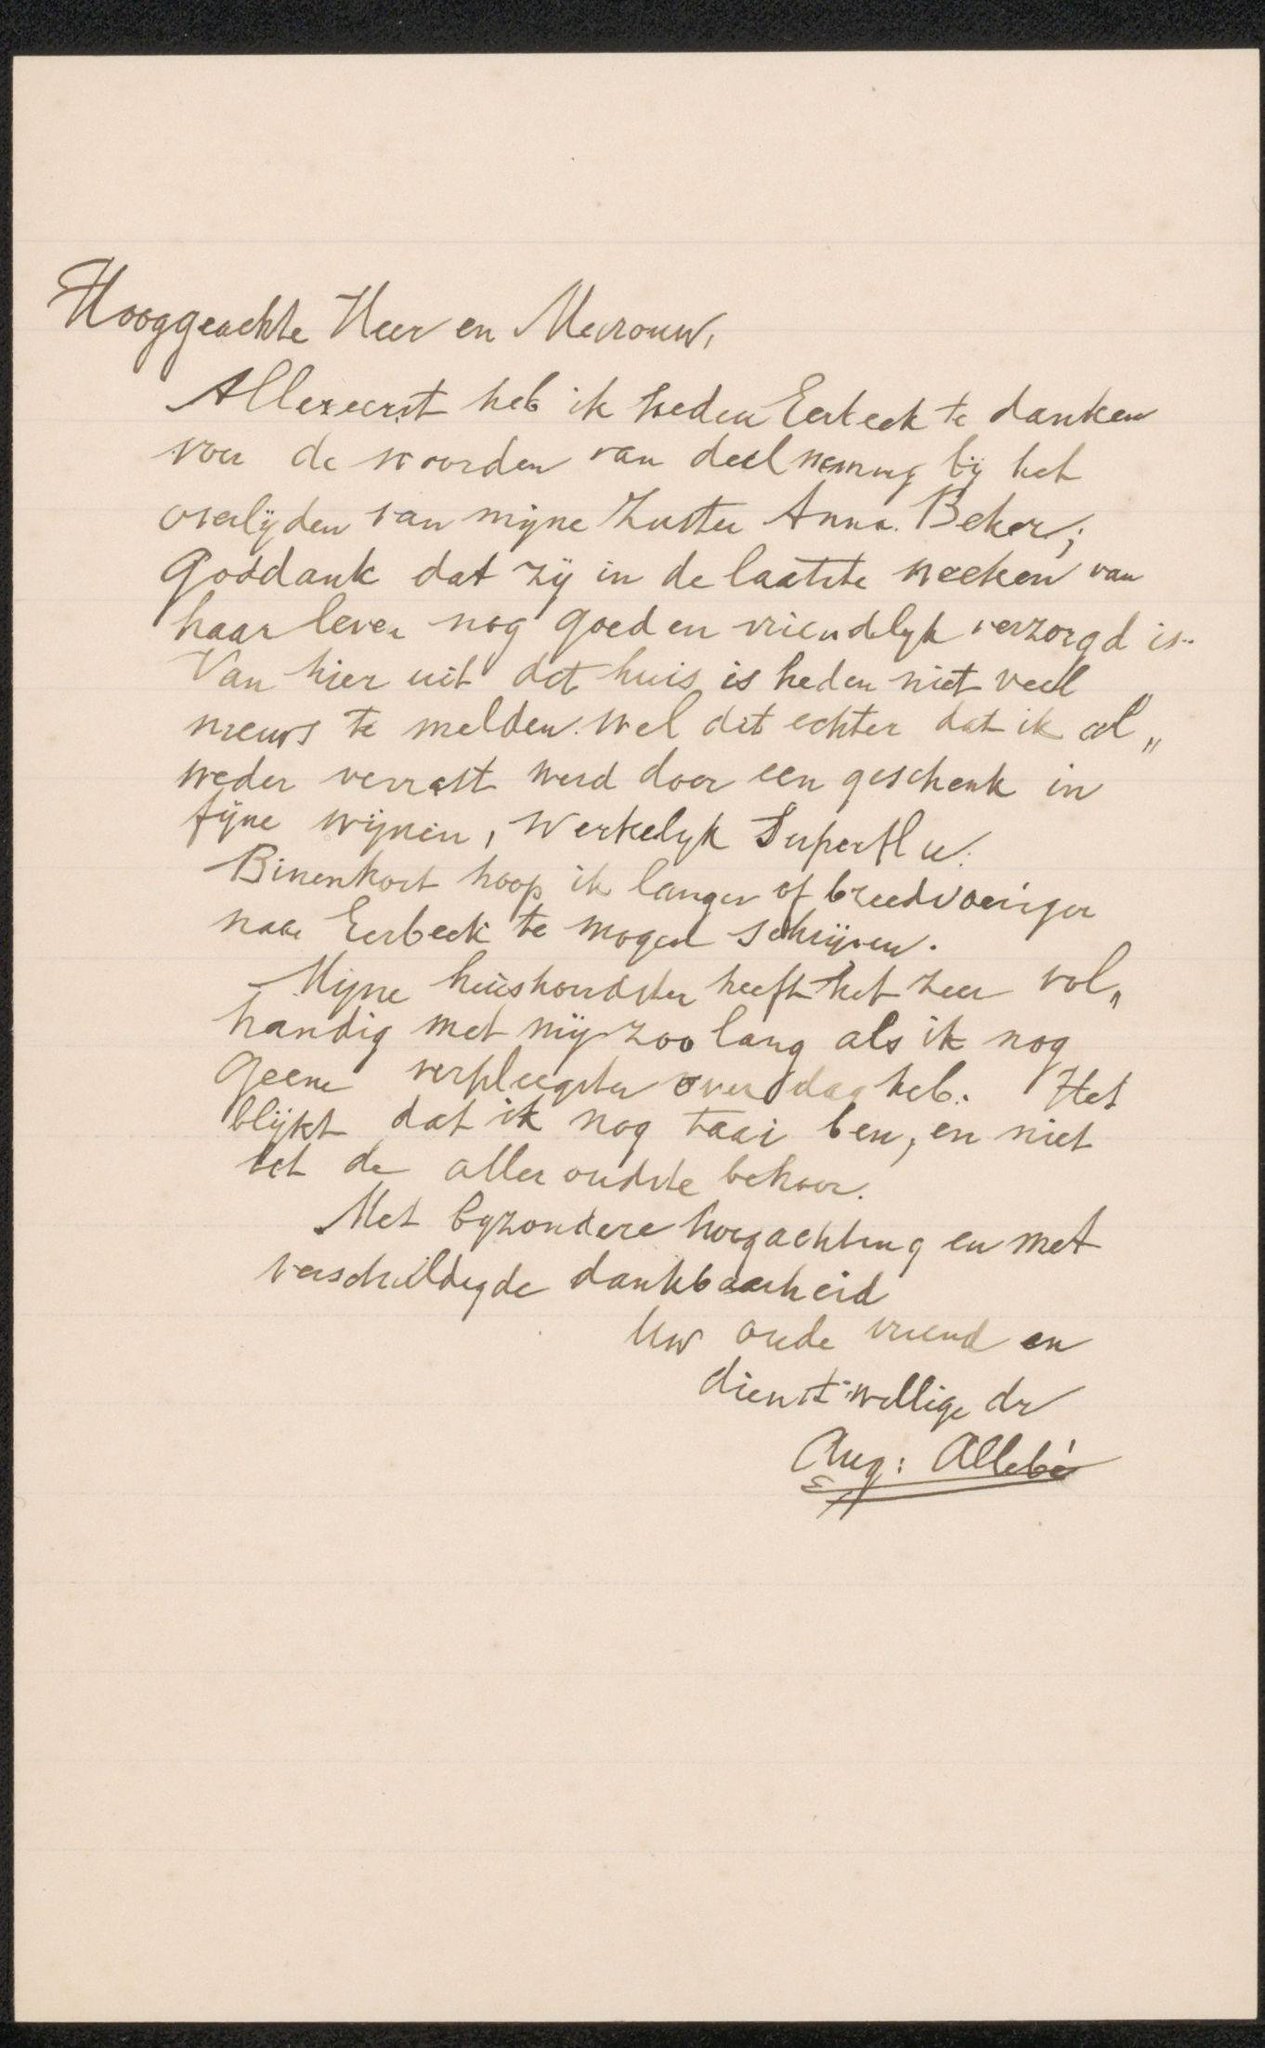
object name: letter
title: Brief aan Max Wilhelm Carl Weber en Anne Antoinette Weber-Van Bosse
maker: august allebé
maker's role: draughtsman, print maker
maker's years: 1838-1927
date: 1862-1927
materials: ink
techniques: pen, writing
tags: amsterdam, anne antoinette weber-van bosse, anna allebé, family life